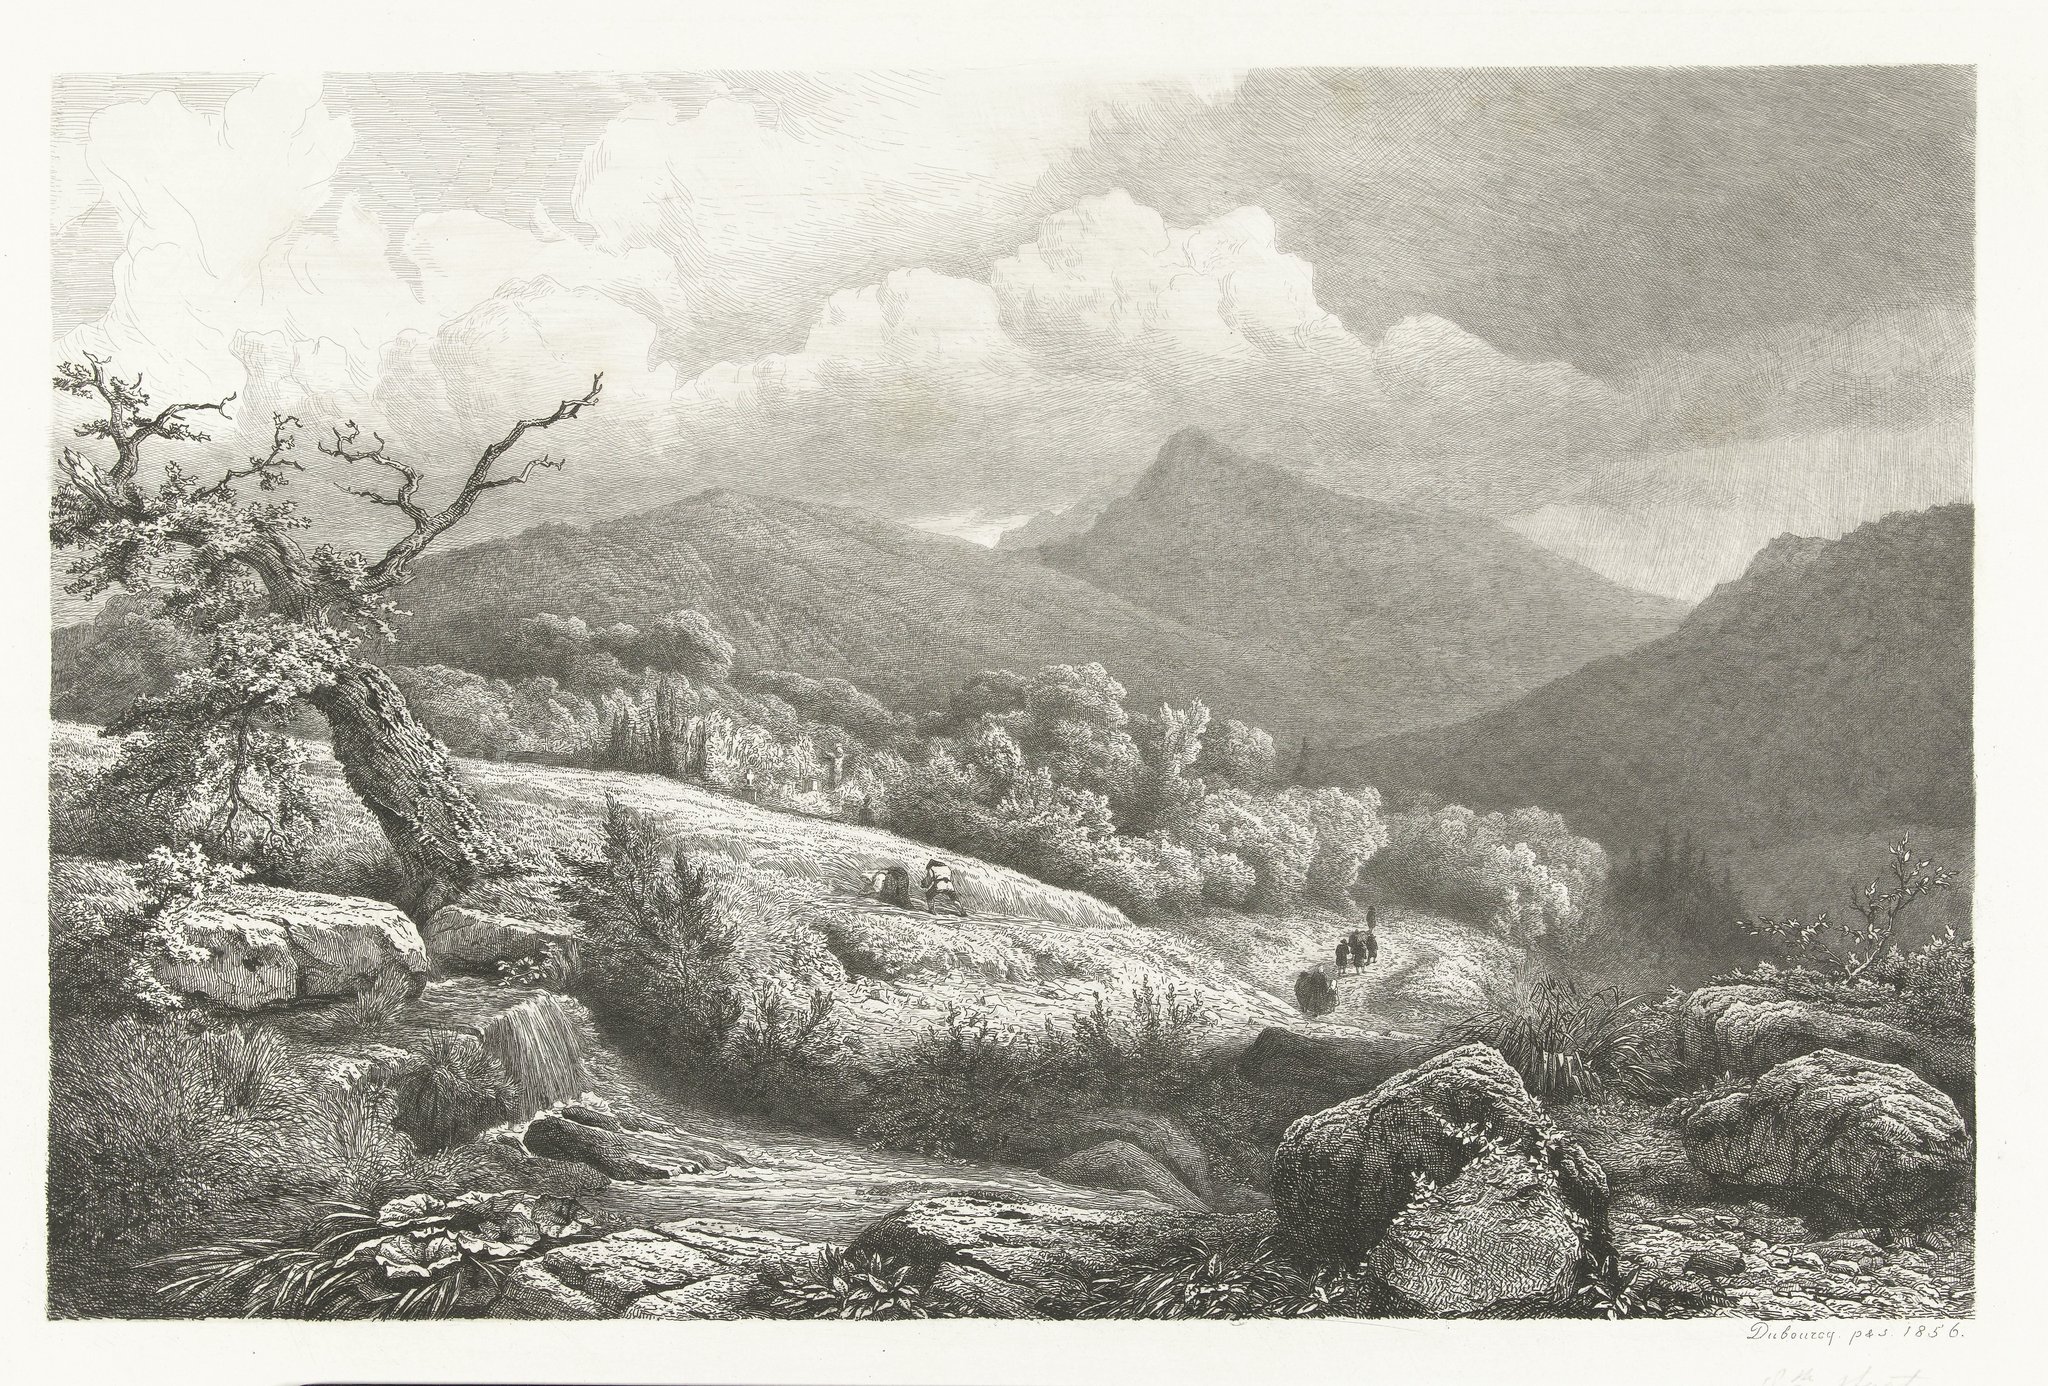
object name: print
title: De begraafplaats te Baden-Baden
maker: pierre louis dubourcq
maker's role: draughtsman, painter, print maker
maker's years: 1815-1873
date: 1856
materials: paper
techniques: etching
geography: netherlands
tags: landscape with other man-made constructions not mentioned above, e.g.: graveyards, playgrounds, etc.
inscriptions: collector's mark: Lugt 2228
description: De begraafplaats te Baden-Baden. Berglandschap met een kleine begrafenisstoet op weg naar de begraafplaats links tussen de bomen. Op de voorgrond een watervalletje.